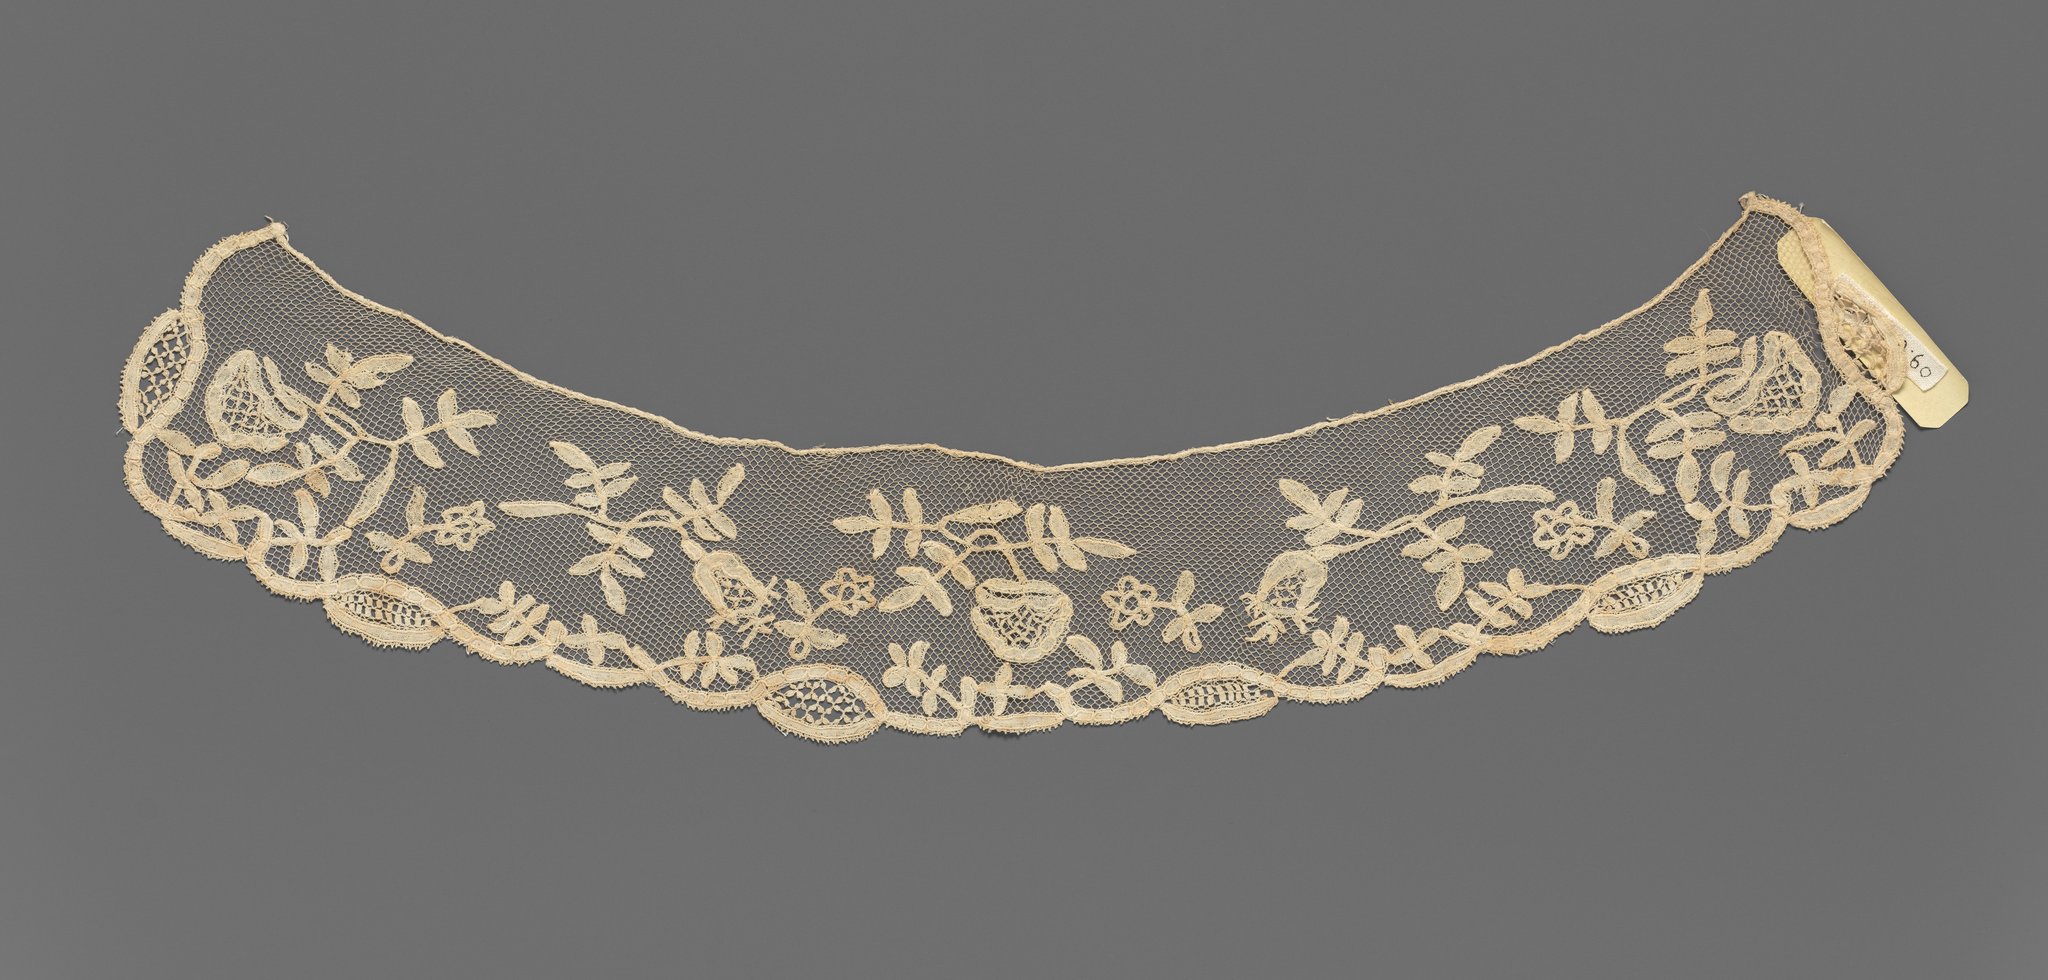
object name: collar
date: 1801-1900